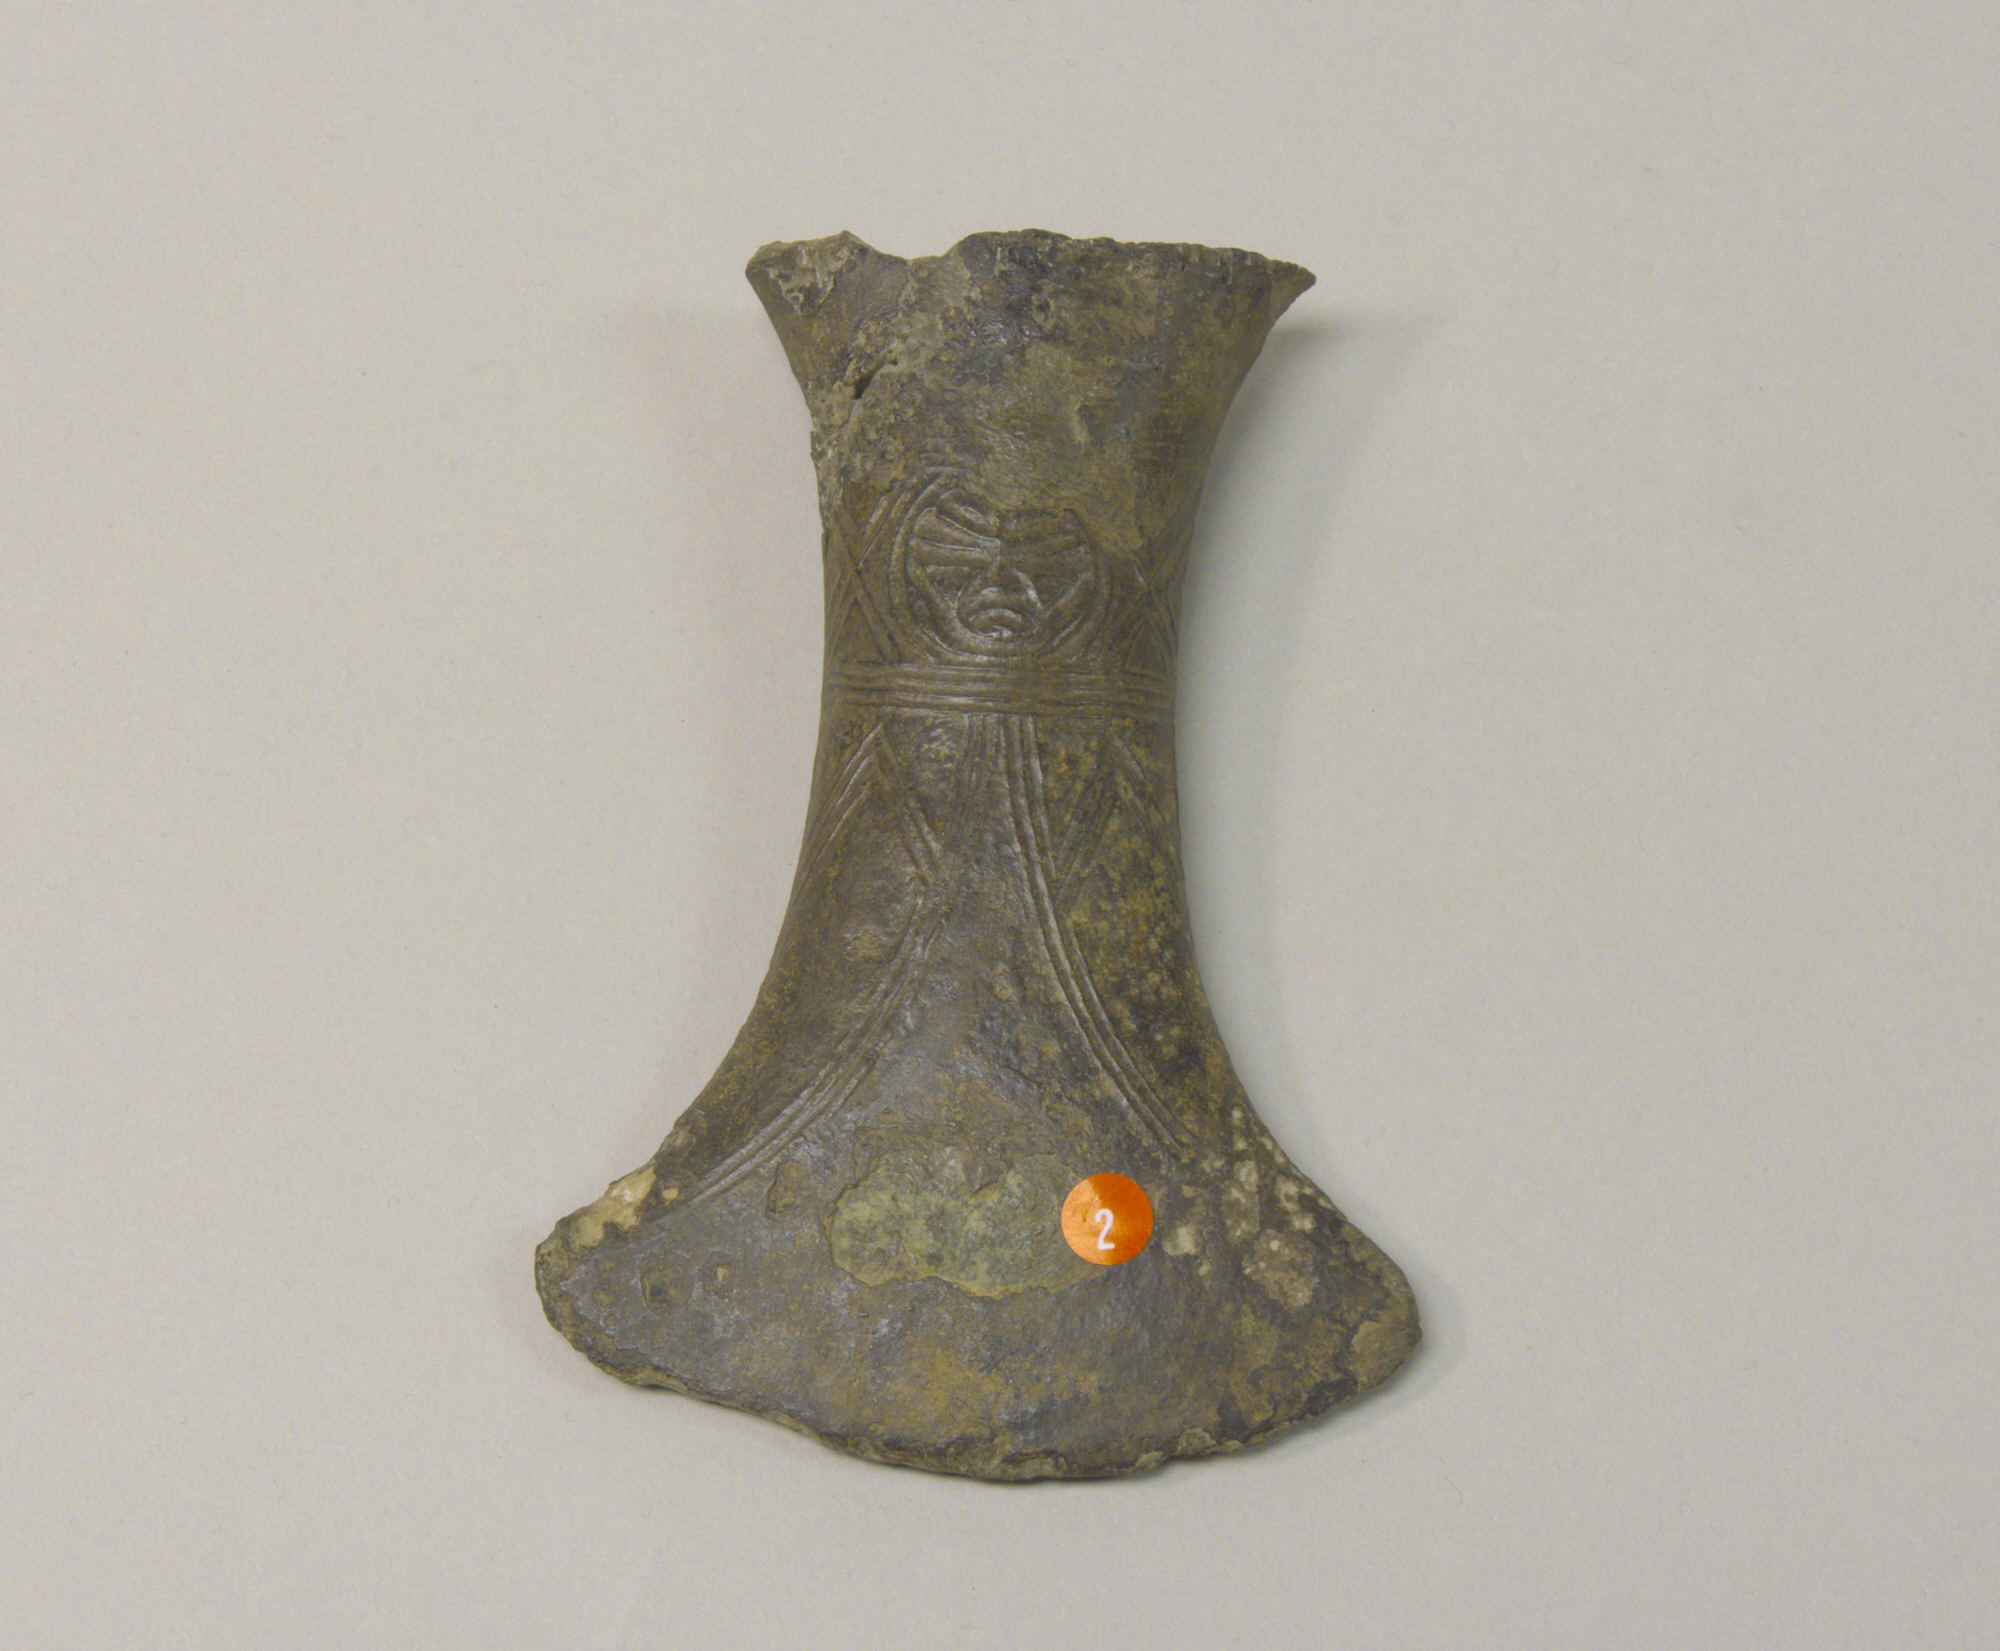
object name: hafted ax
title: Hafted Flask-Shaped Ax with Face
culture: indonesian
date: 500 BCE-300 CE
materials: bronze